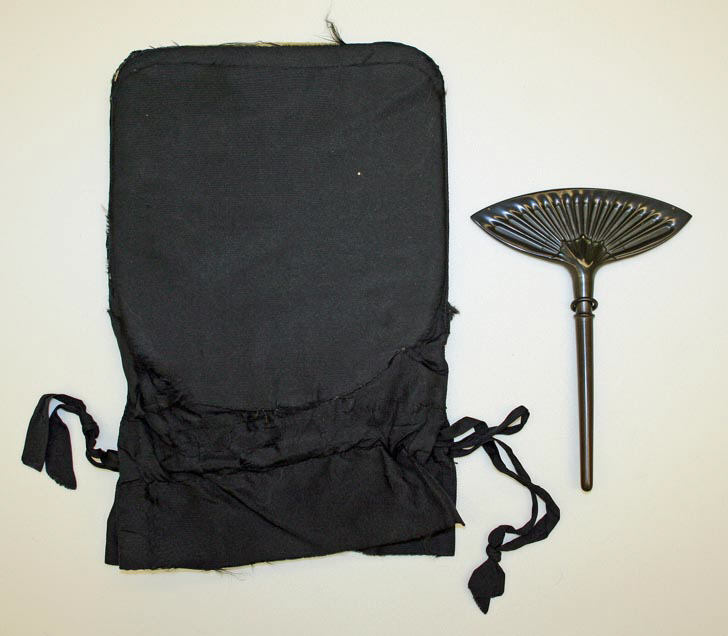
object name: fan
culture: american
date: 1882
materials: plastic, silk